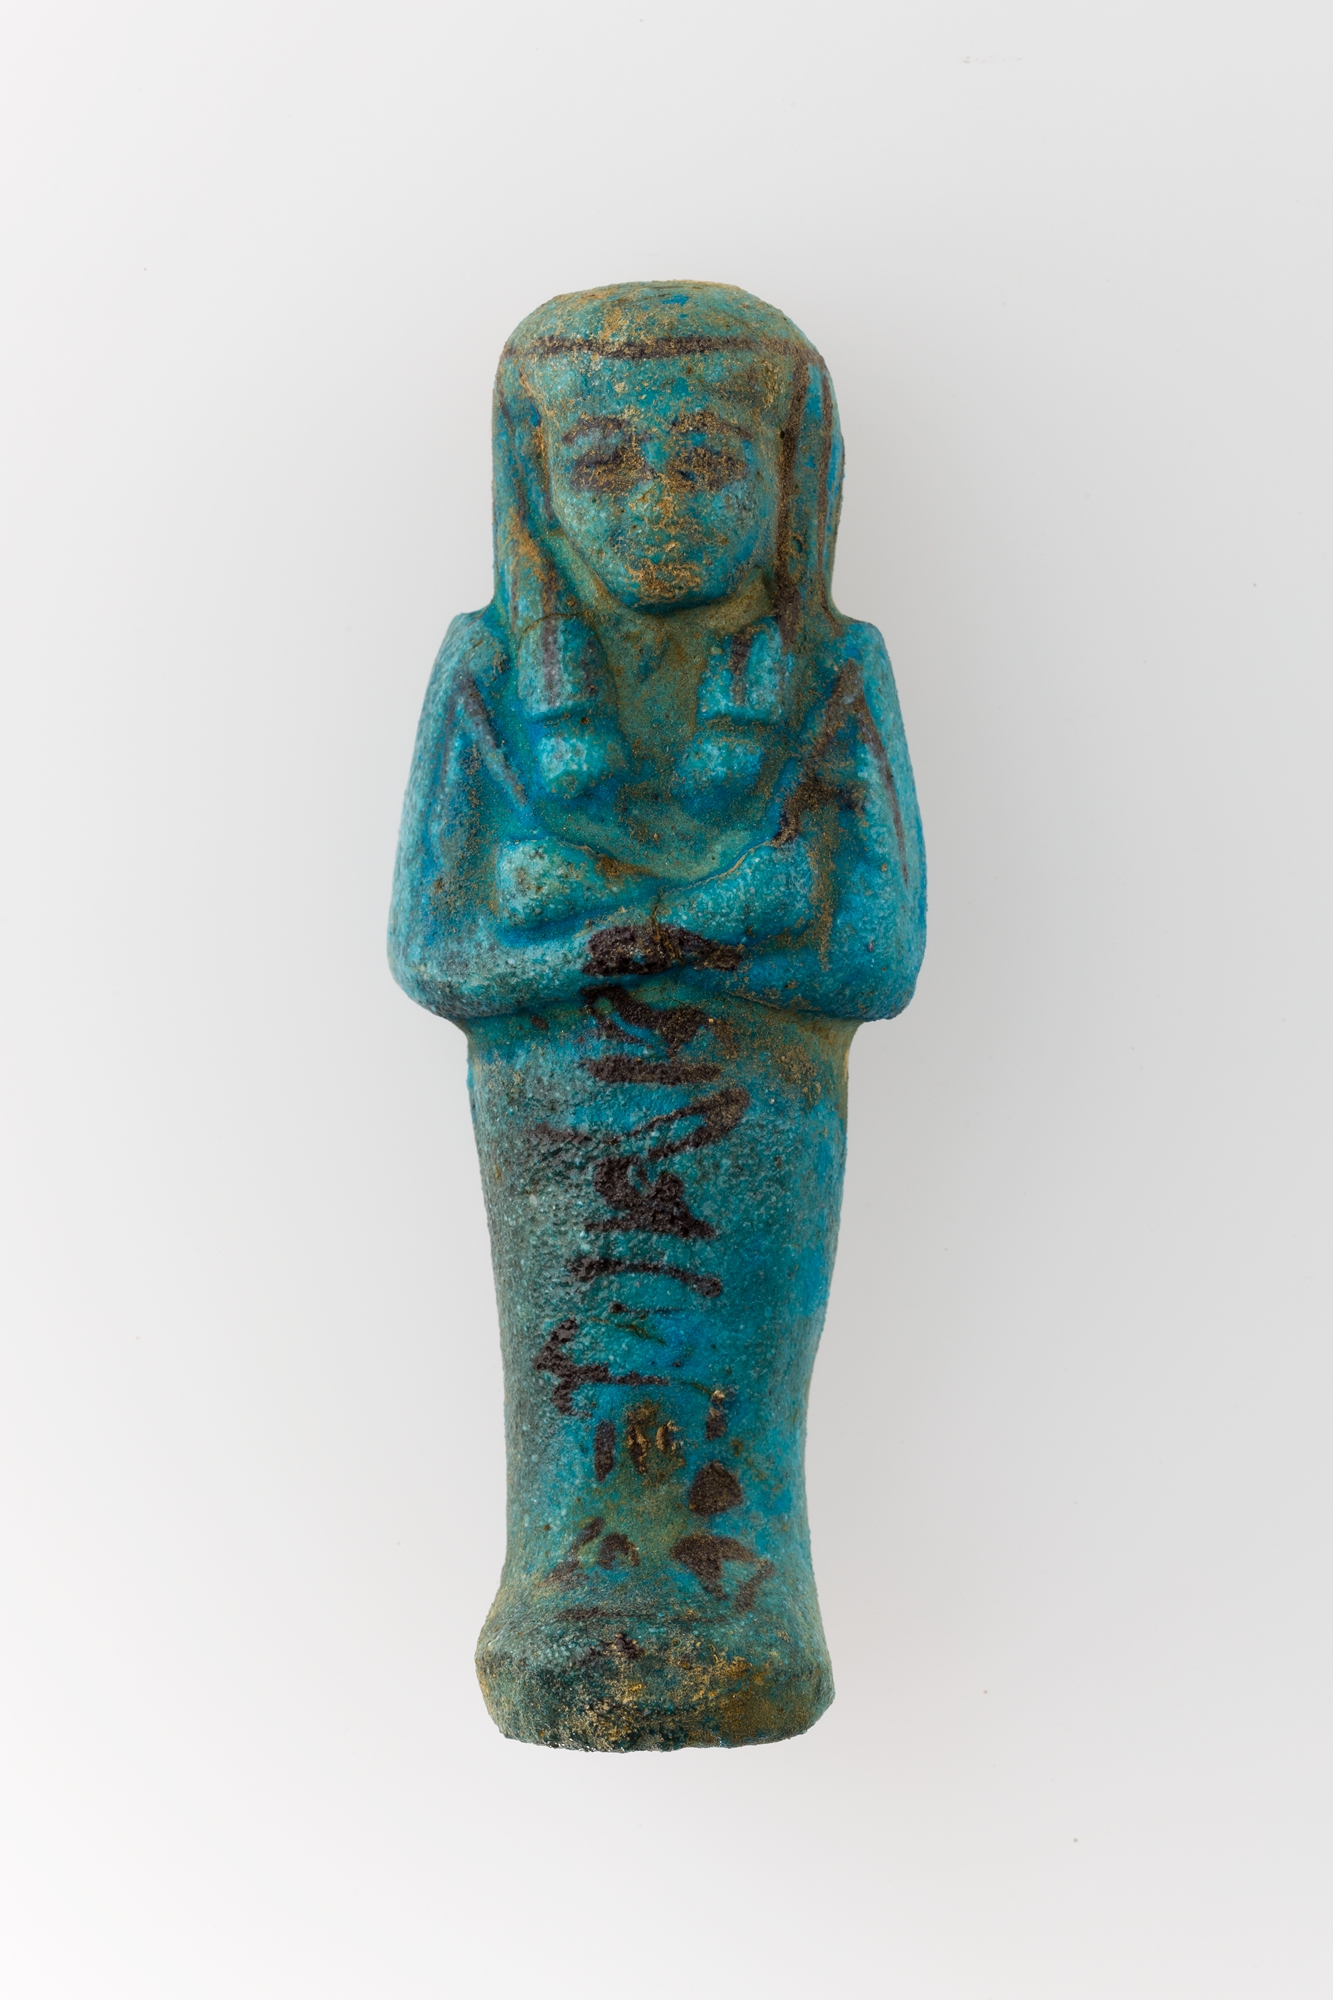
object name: shabti, henettawy c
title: Worker Shabti of Henettawy (C), Daughter of Isetemkheb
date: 990-970 BCE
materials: faience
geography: egypt